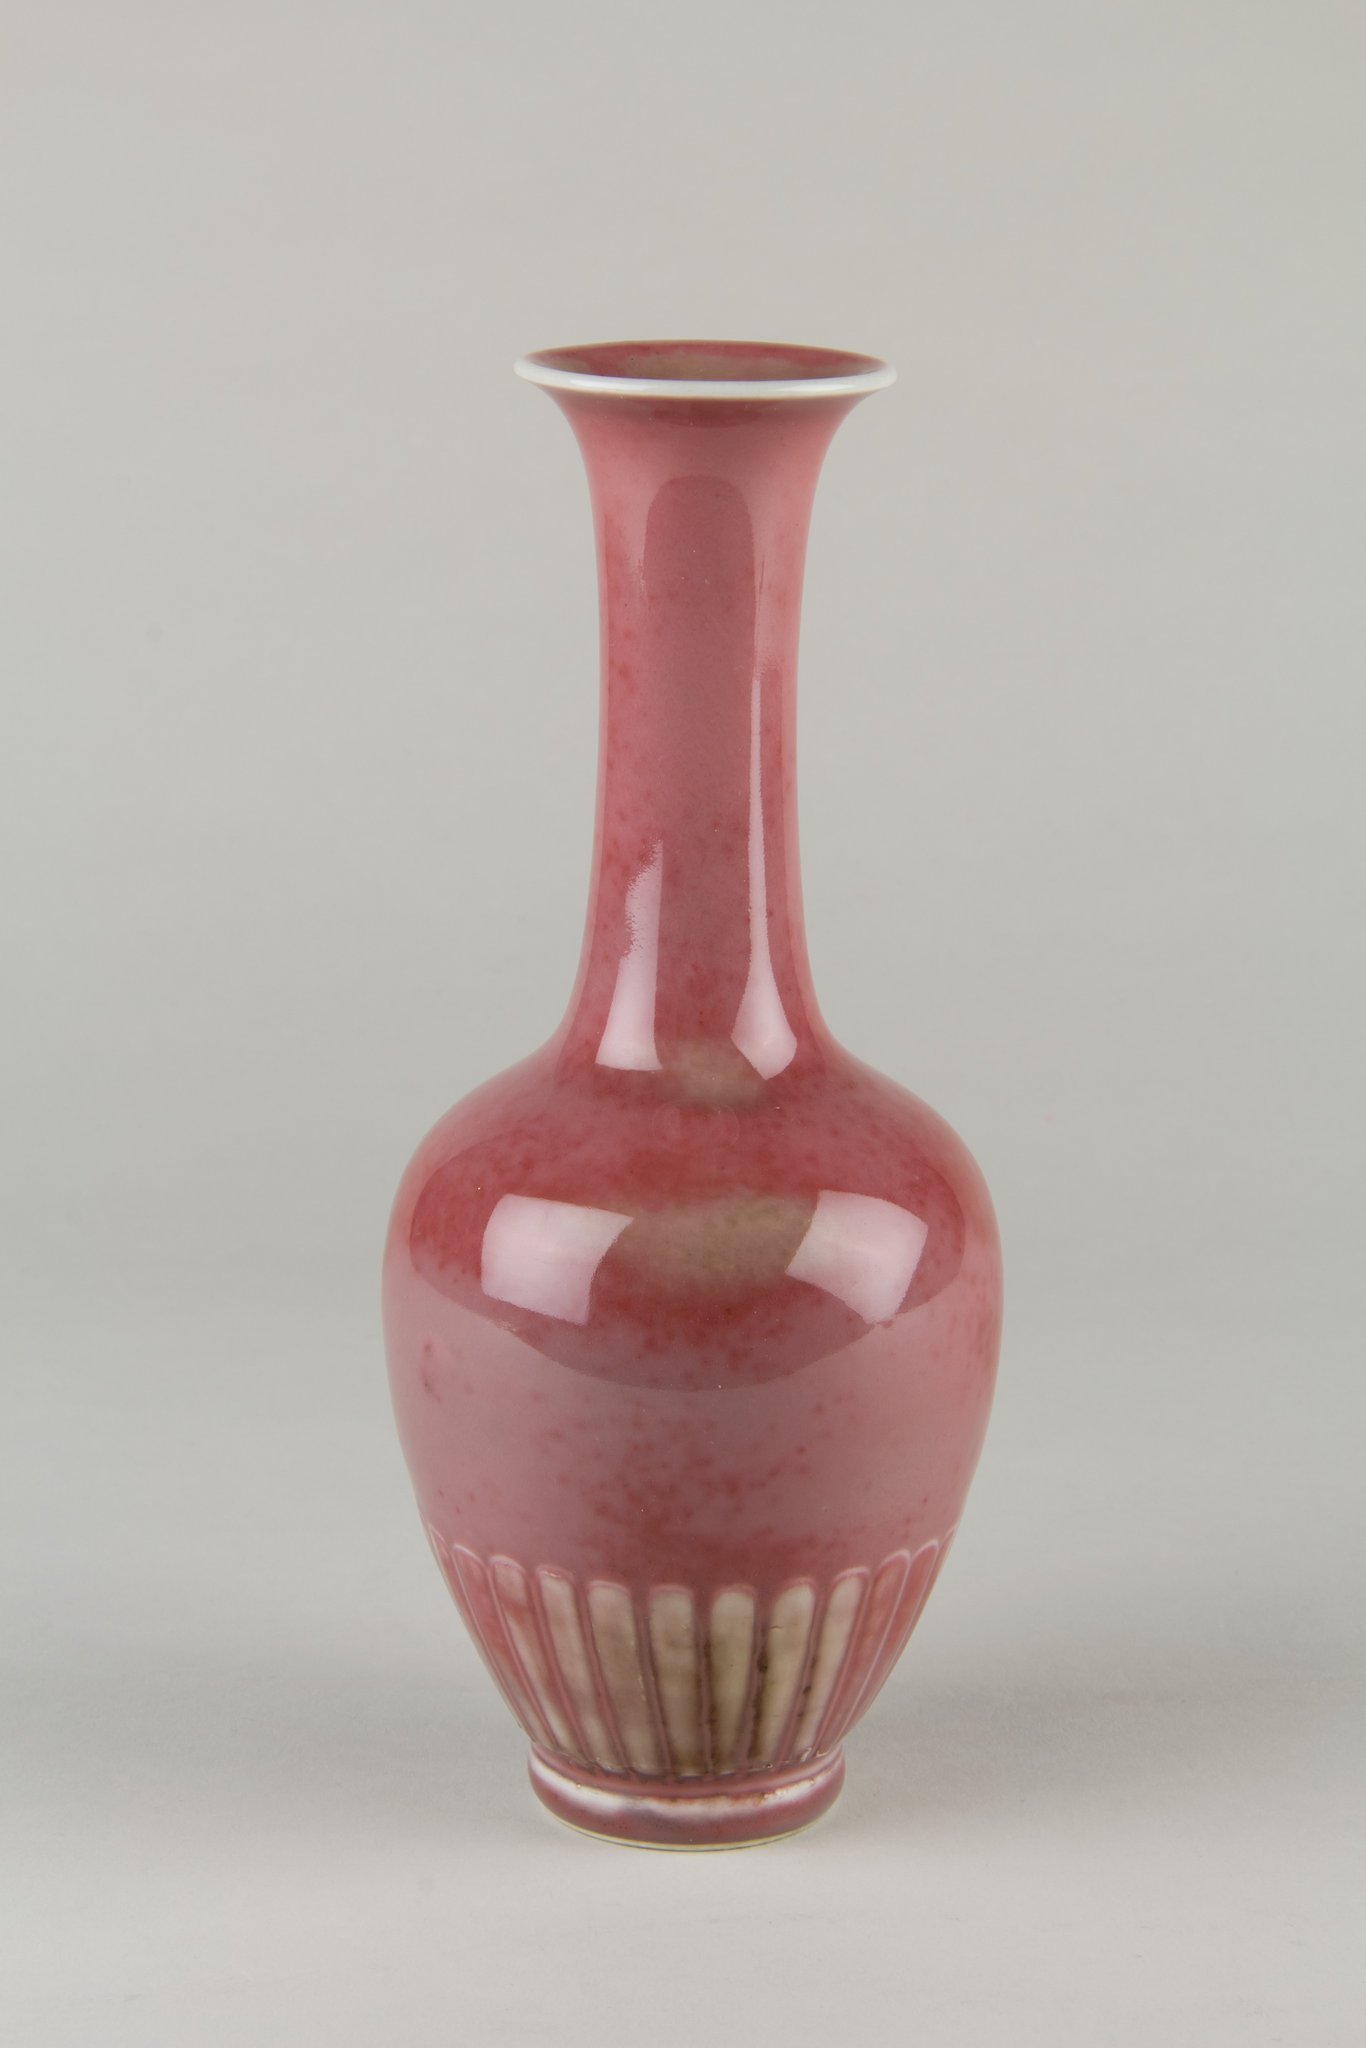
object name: bottle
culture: chinese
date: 1662-1722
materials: porcelain